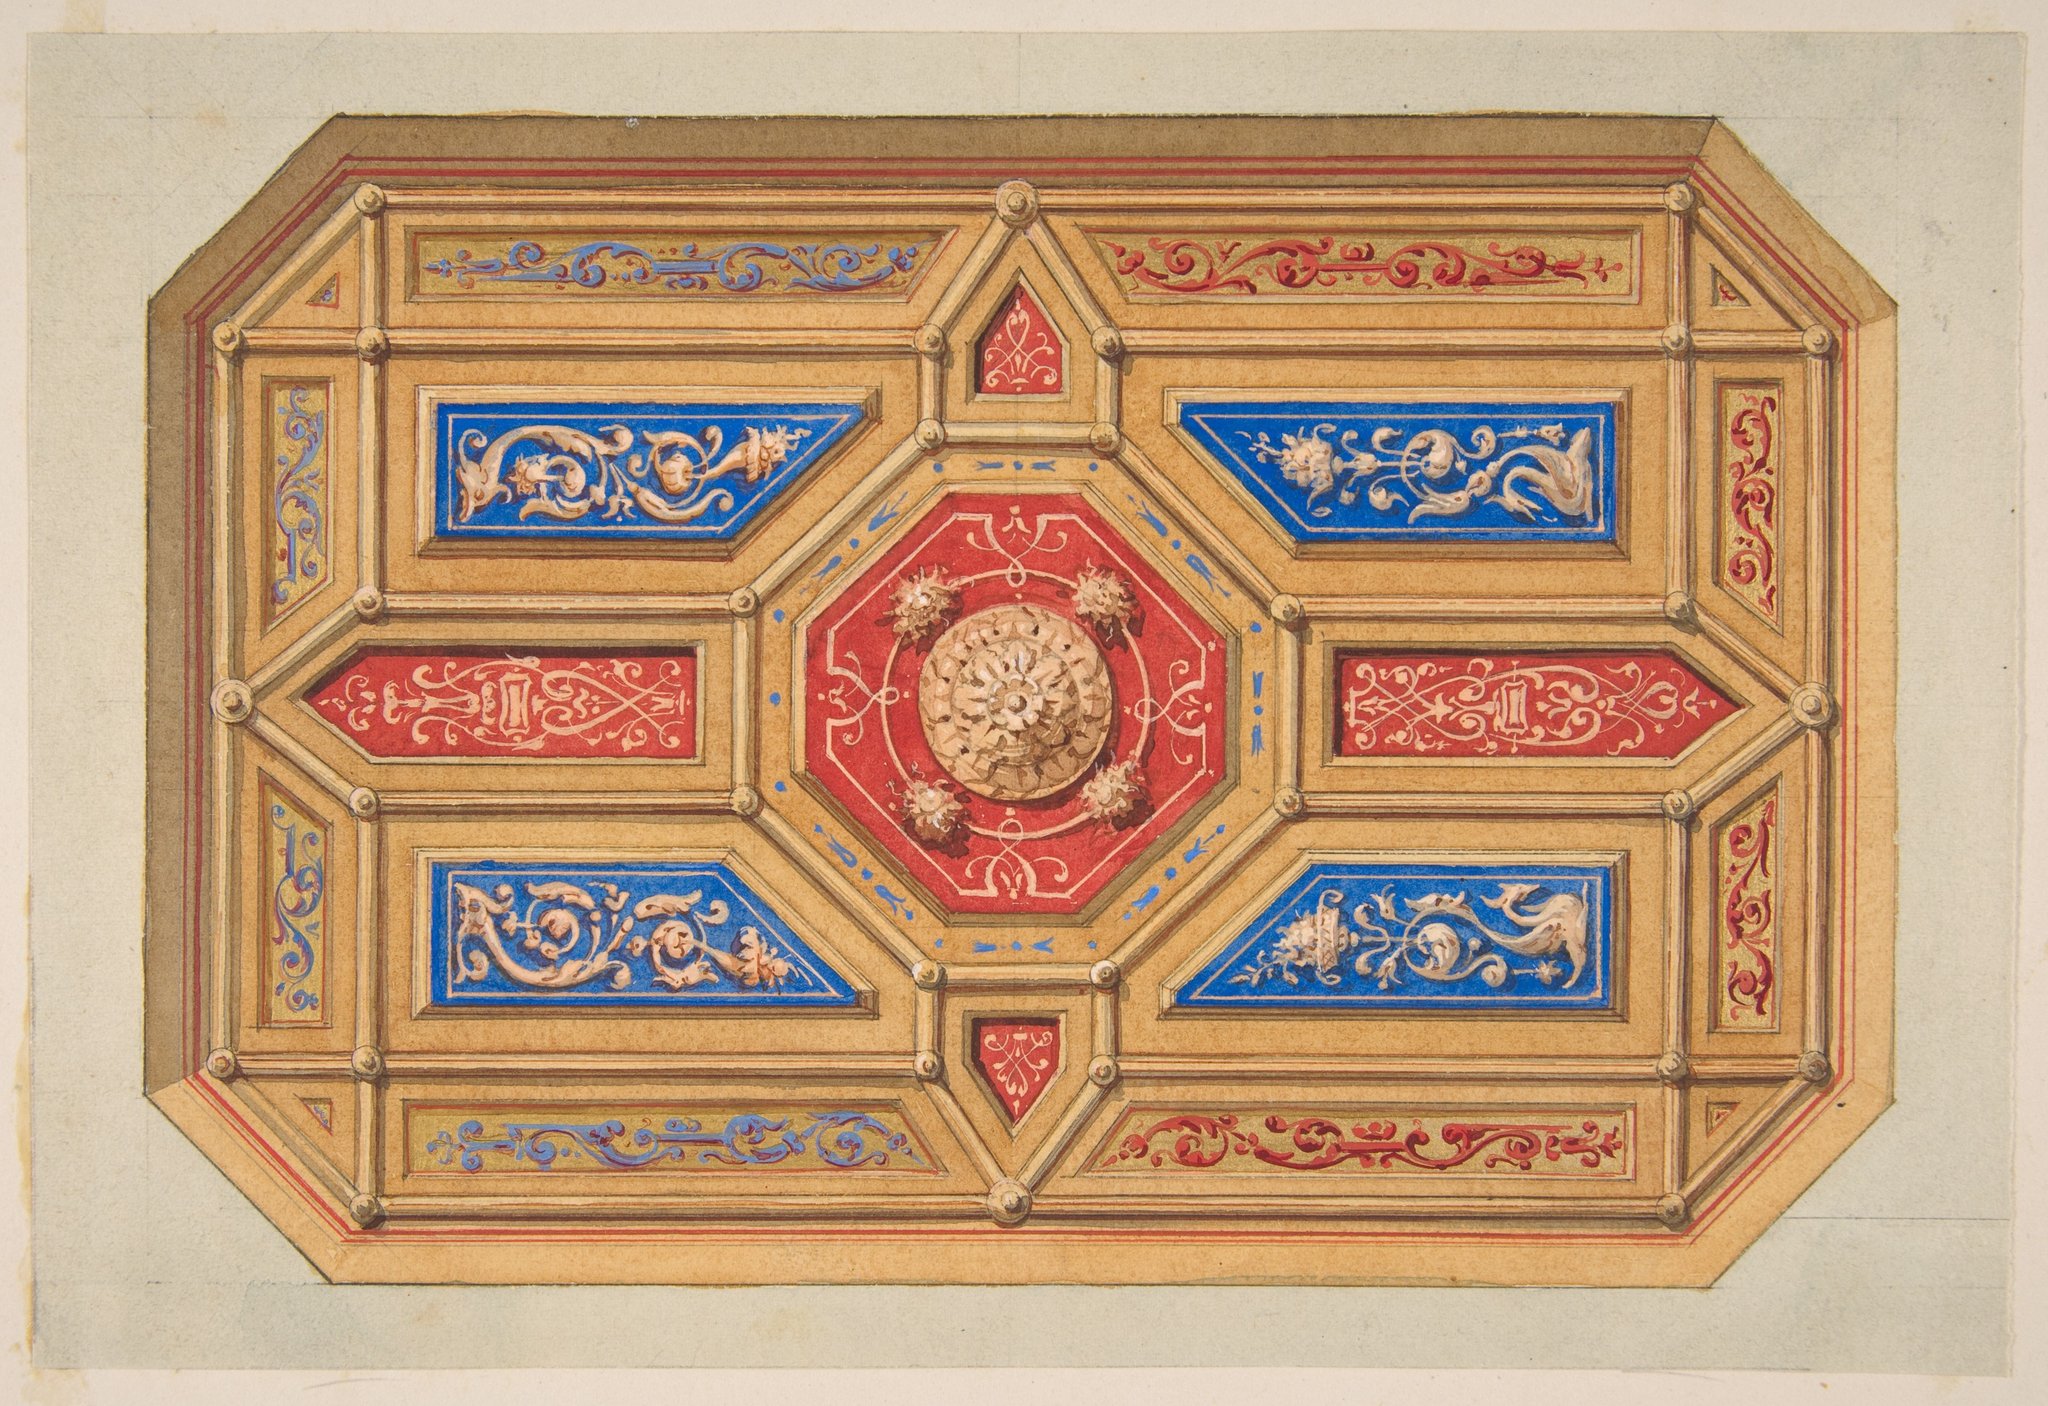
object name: drawing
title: Design for a paneled ceiling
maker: jules-edmond-charles lachaise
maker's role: artist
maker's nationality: french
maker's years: 1897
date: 1801-1900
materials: ink, watercolor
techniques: pen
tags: flowers